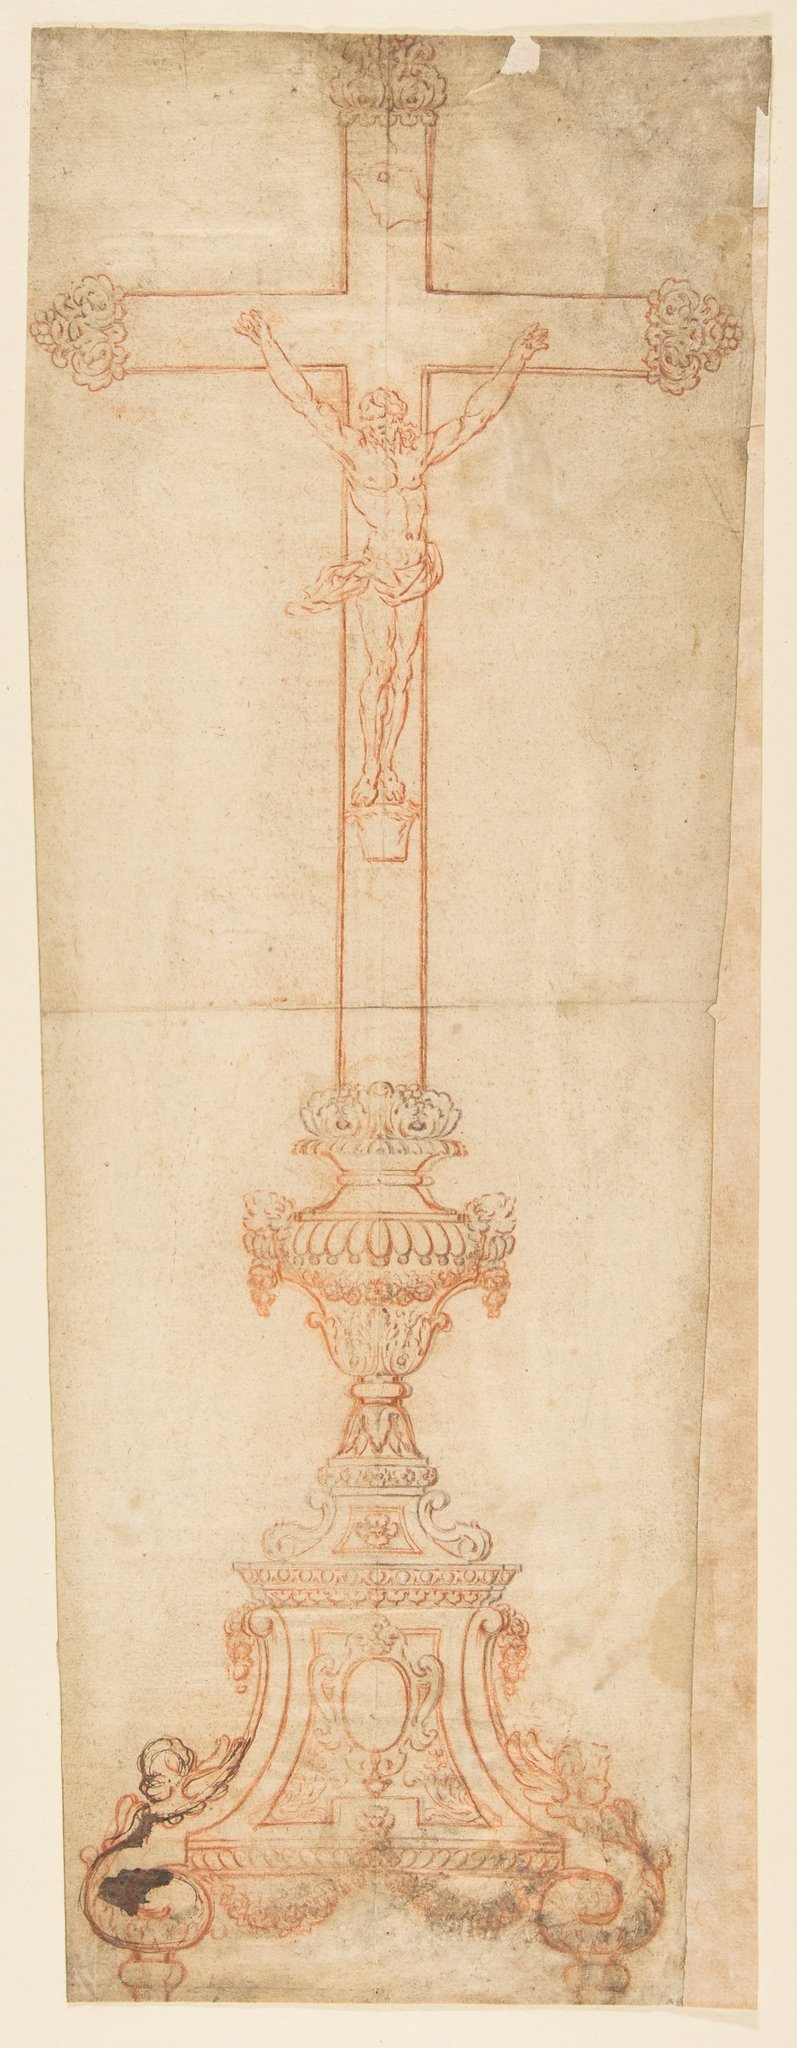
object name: collection ornament architecture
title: Design for a Crucifix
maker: anonymous, french, 18th century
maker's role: artist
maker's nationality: french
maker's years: 1700-1800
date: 1701-1800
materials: chalk, graphite, ink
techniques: pen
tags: christ,cross,crucifixion